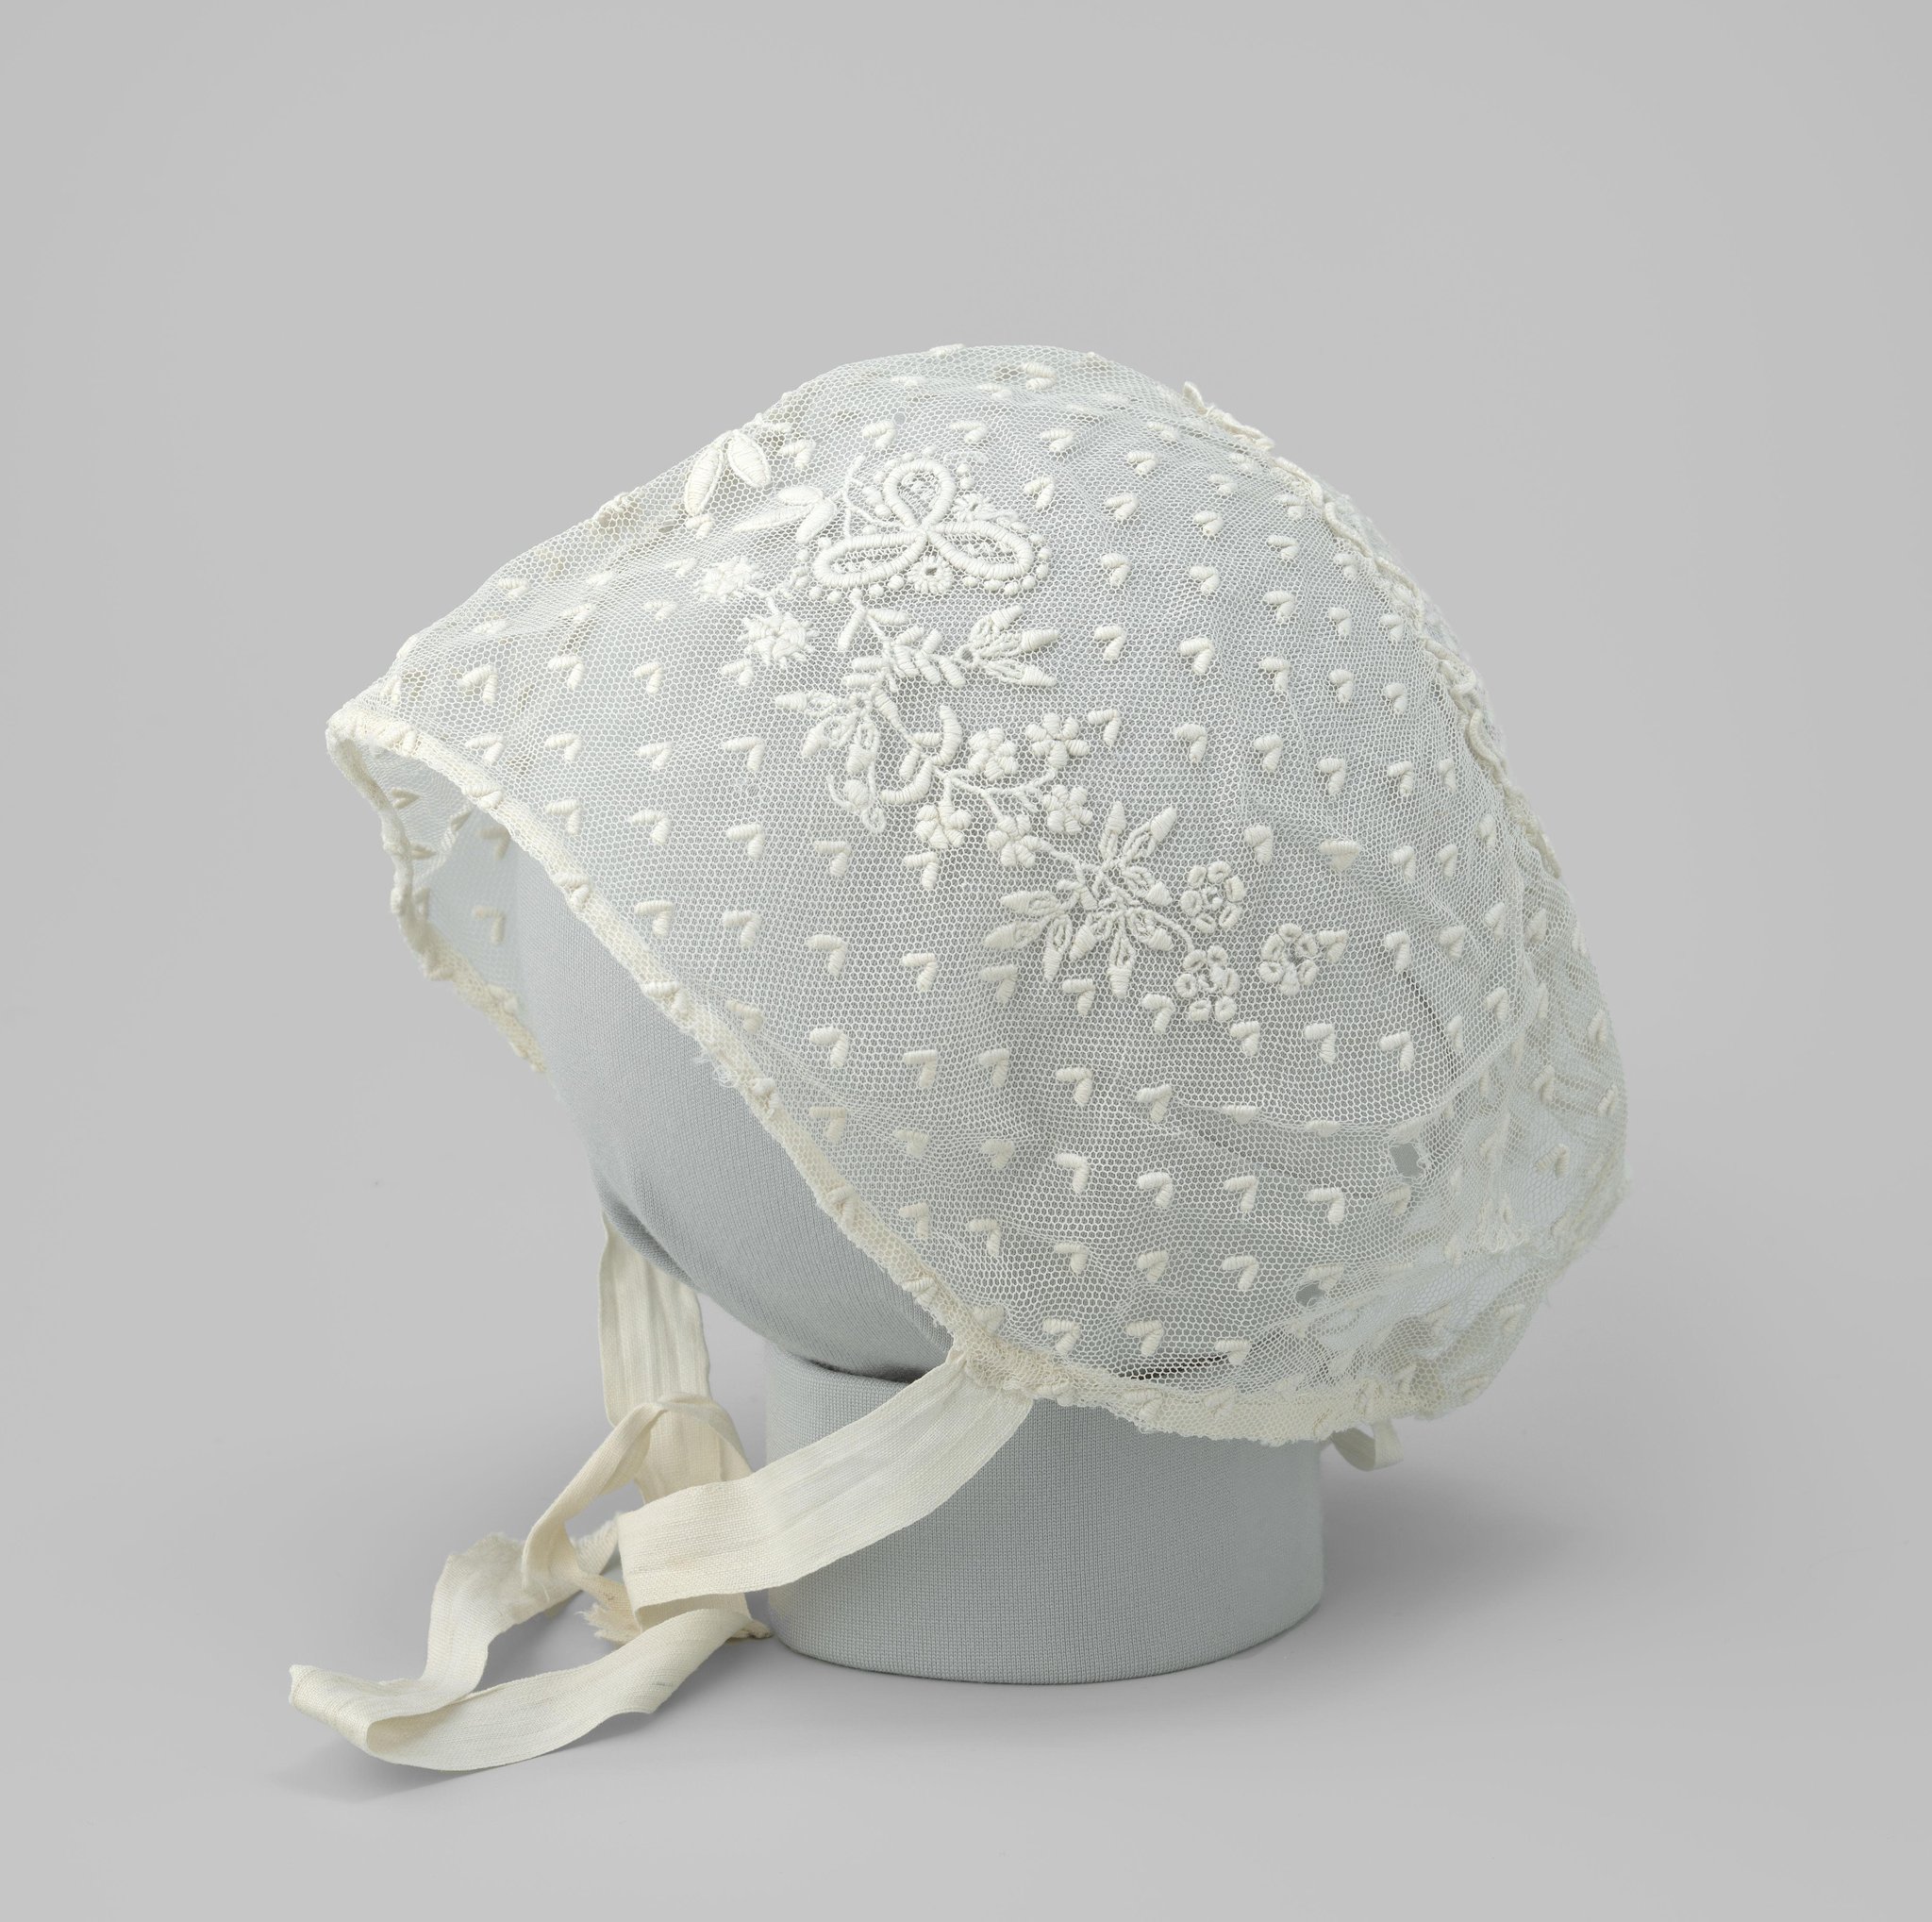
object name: babymuts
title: Babymuts van witte tule met wit borduurwerk en twee strikken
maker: Anonymous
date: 1800-1900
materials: lace, fiber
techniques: embroidered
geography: netherlands